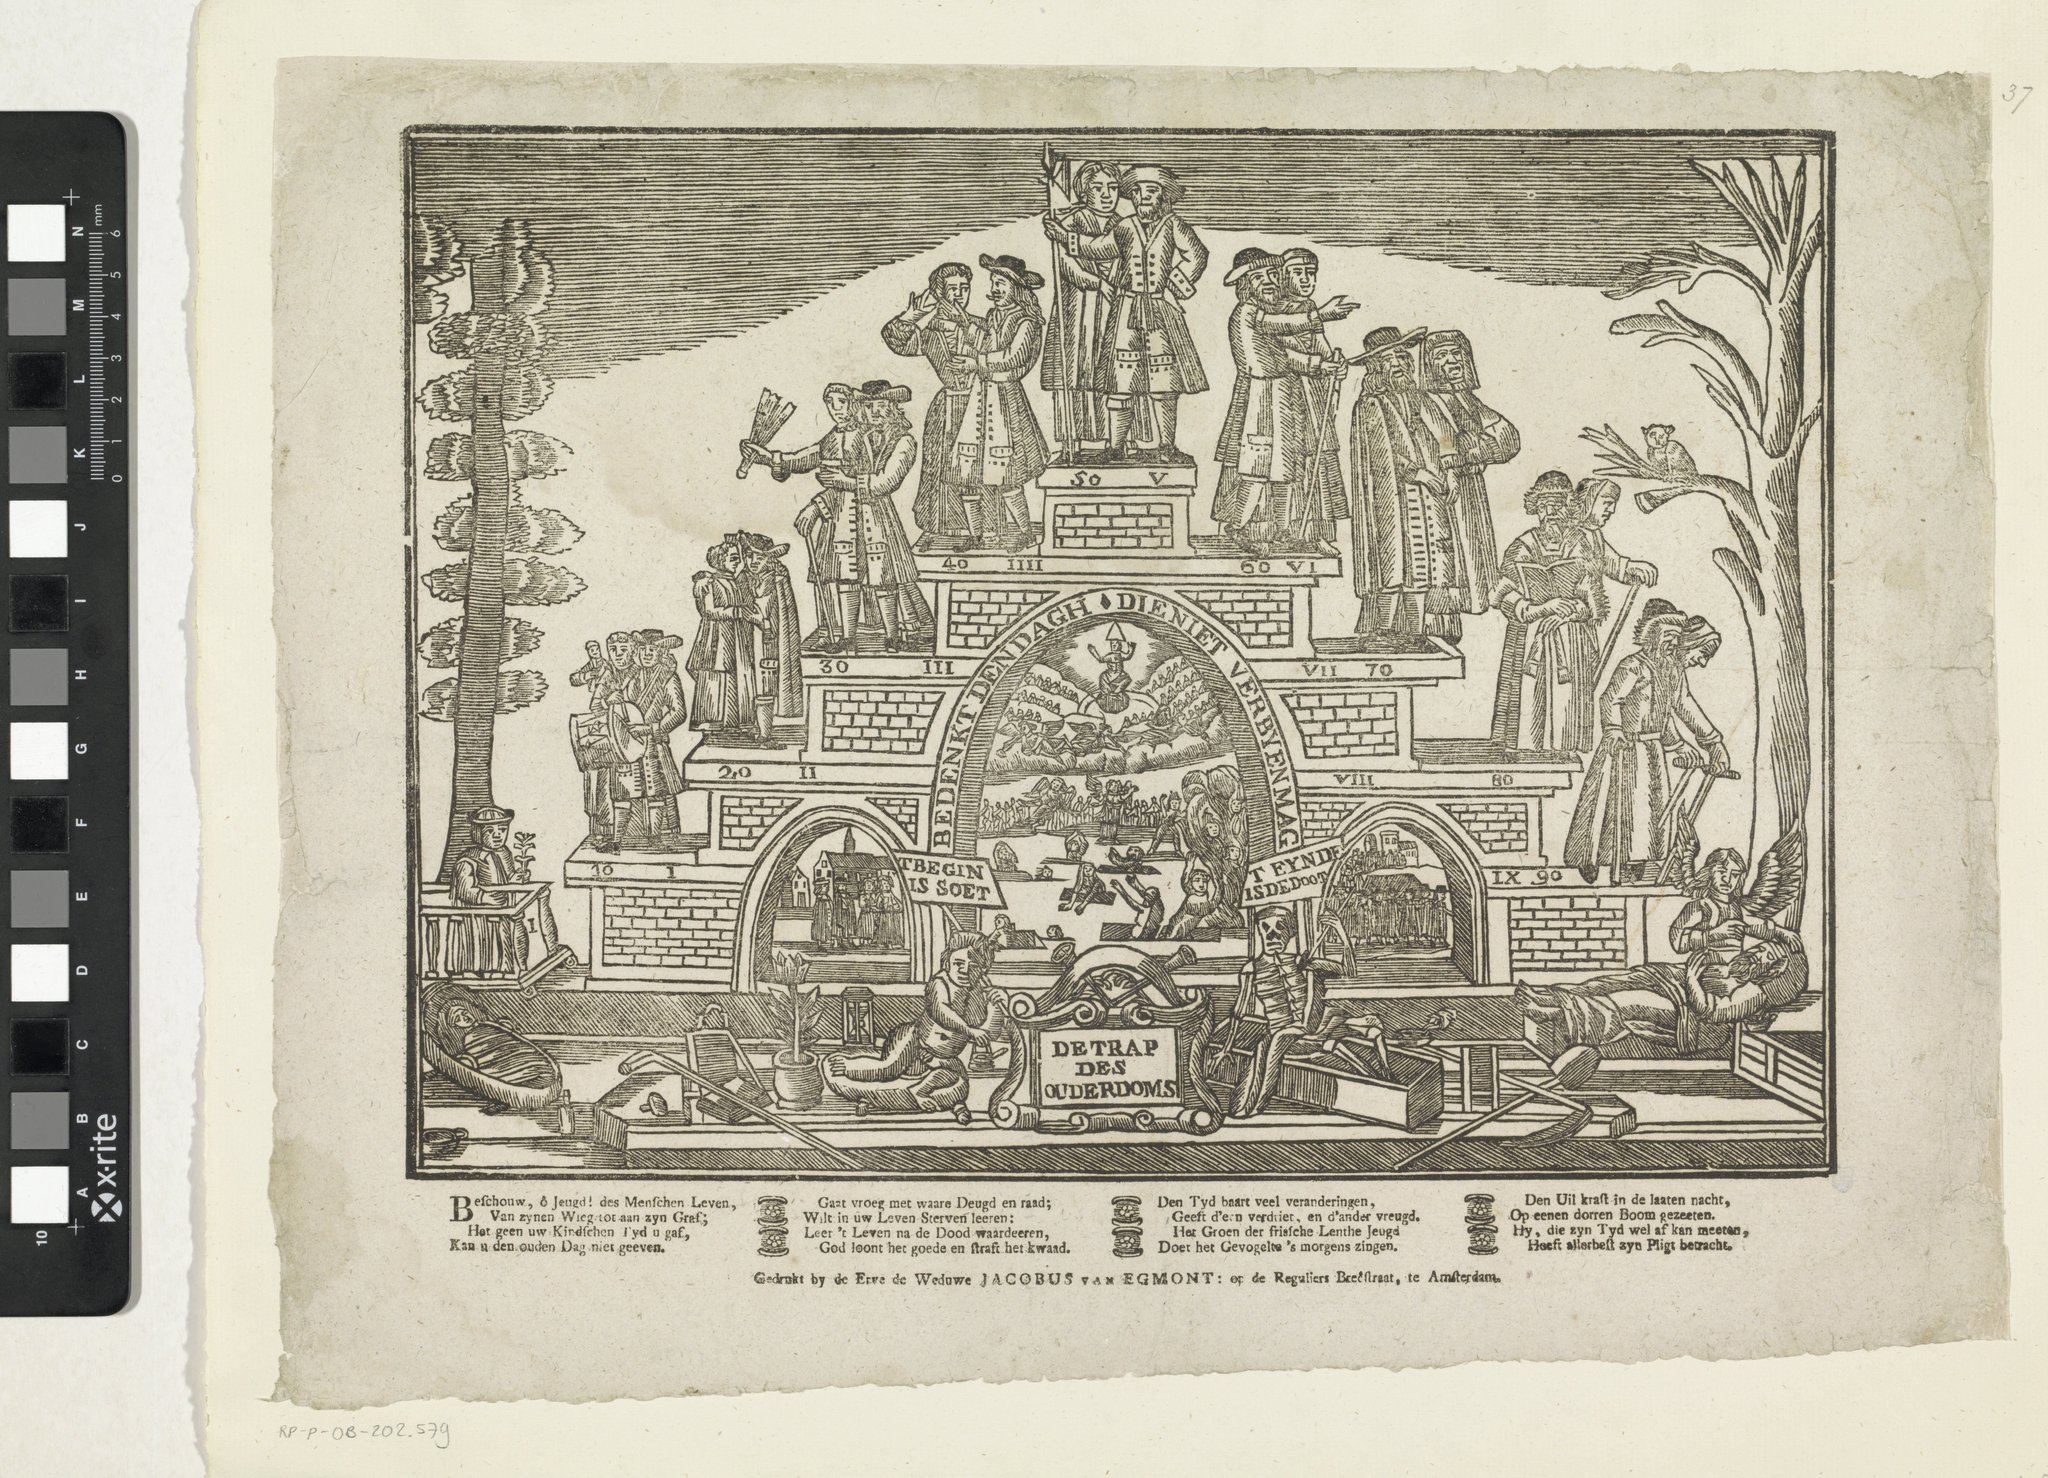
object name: popular print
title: De trap des ouderdoms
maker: Anonymous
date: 1761-1804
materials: paper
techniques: letterpress printing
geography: amsterdam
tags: last judgement, the ages of man represented by a staircase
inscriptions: collector's mark: Lugt 2760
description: Een trap des ouderdoms: een parentrap. Op de treden van de trap, in de vorm van een brug, staan mannen en vrouwen in de leeftijd van 0 tot 100 jaar. Onder de brug een voorstelling van het Laatste Oordeel. Op de poort de tekst: Bedenkt den dagh die niet verblyen mag. Linksvoor een putto met de tekst: T Begin is soet, rechtsvoor de dood als skelet met de tekst: T Eynde is de Doot. Onder de voorstelling een zestienregelig vers in vier kolommen.